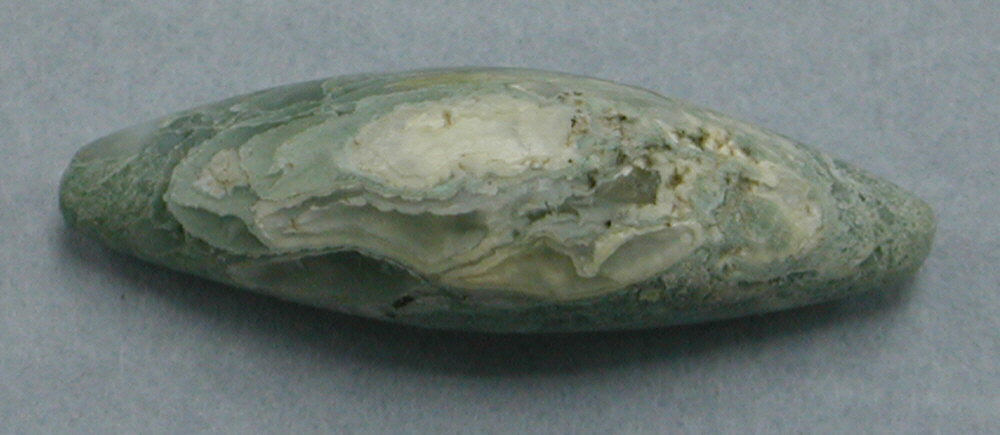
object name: ritual stone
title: Polishing Stone (pulidor)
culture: mexican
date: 1501-1600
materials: stone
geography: mexico